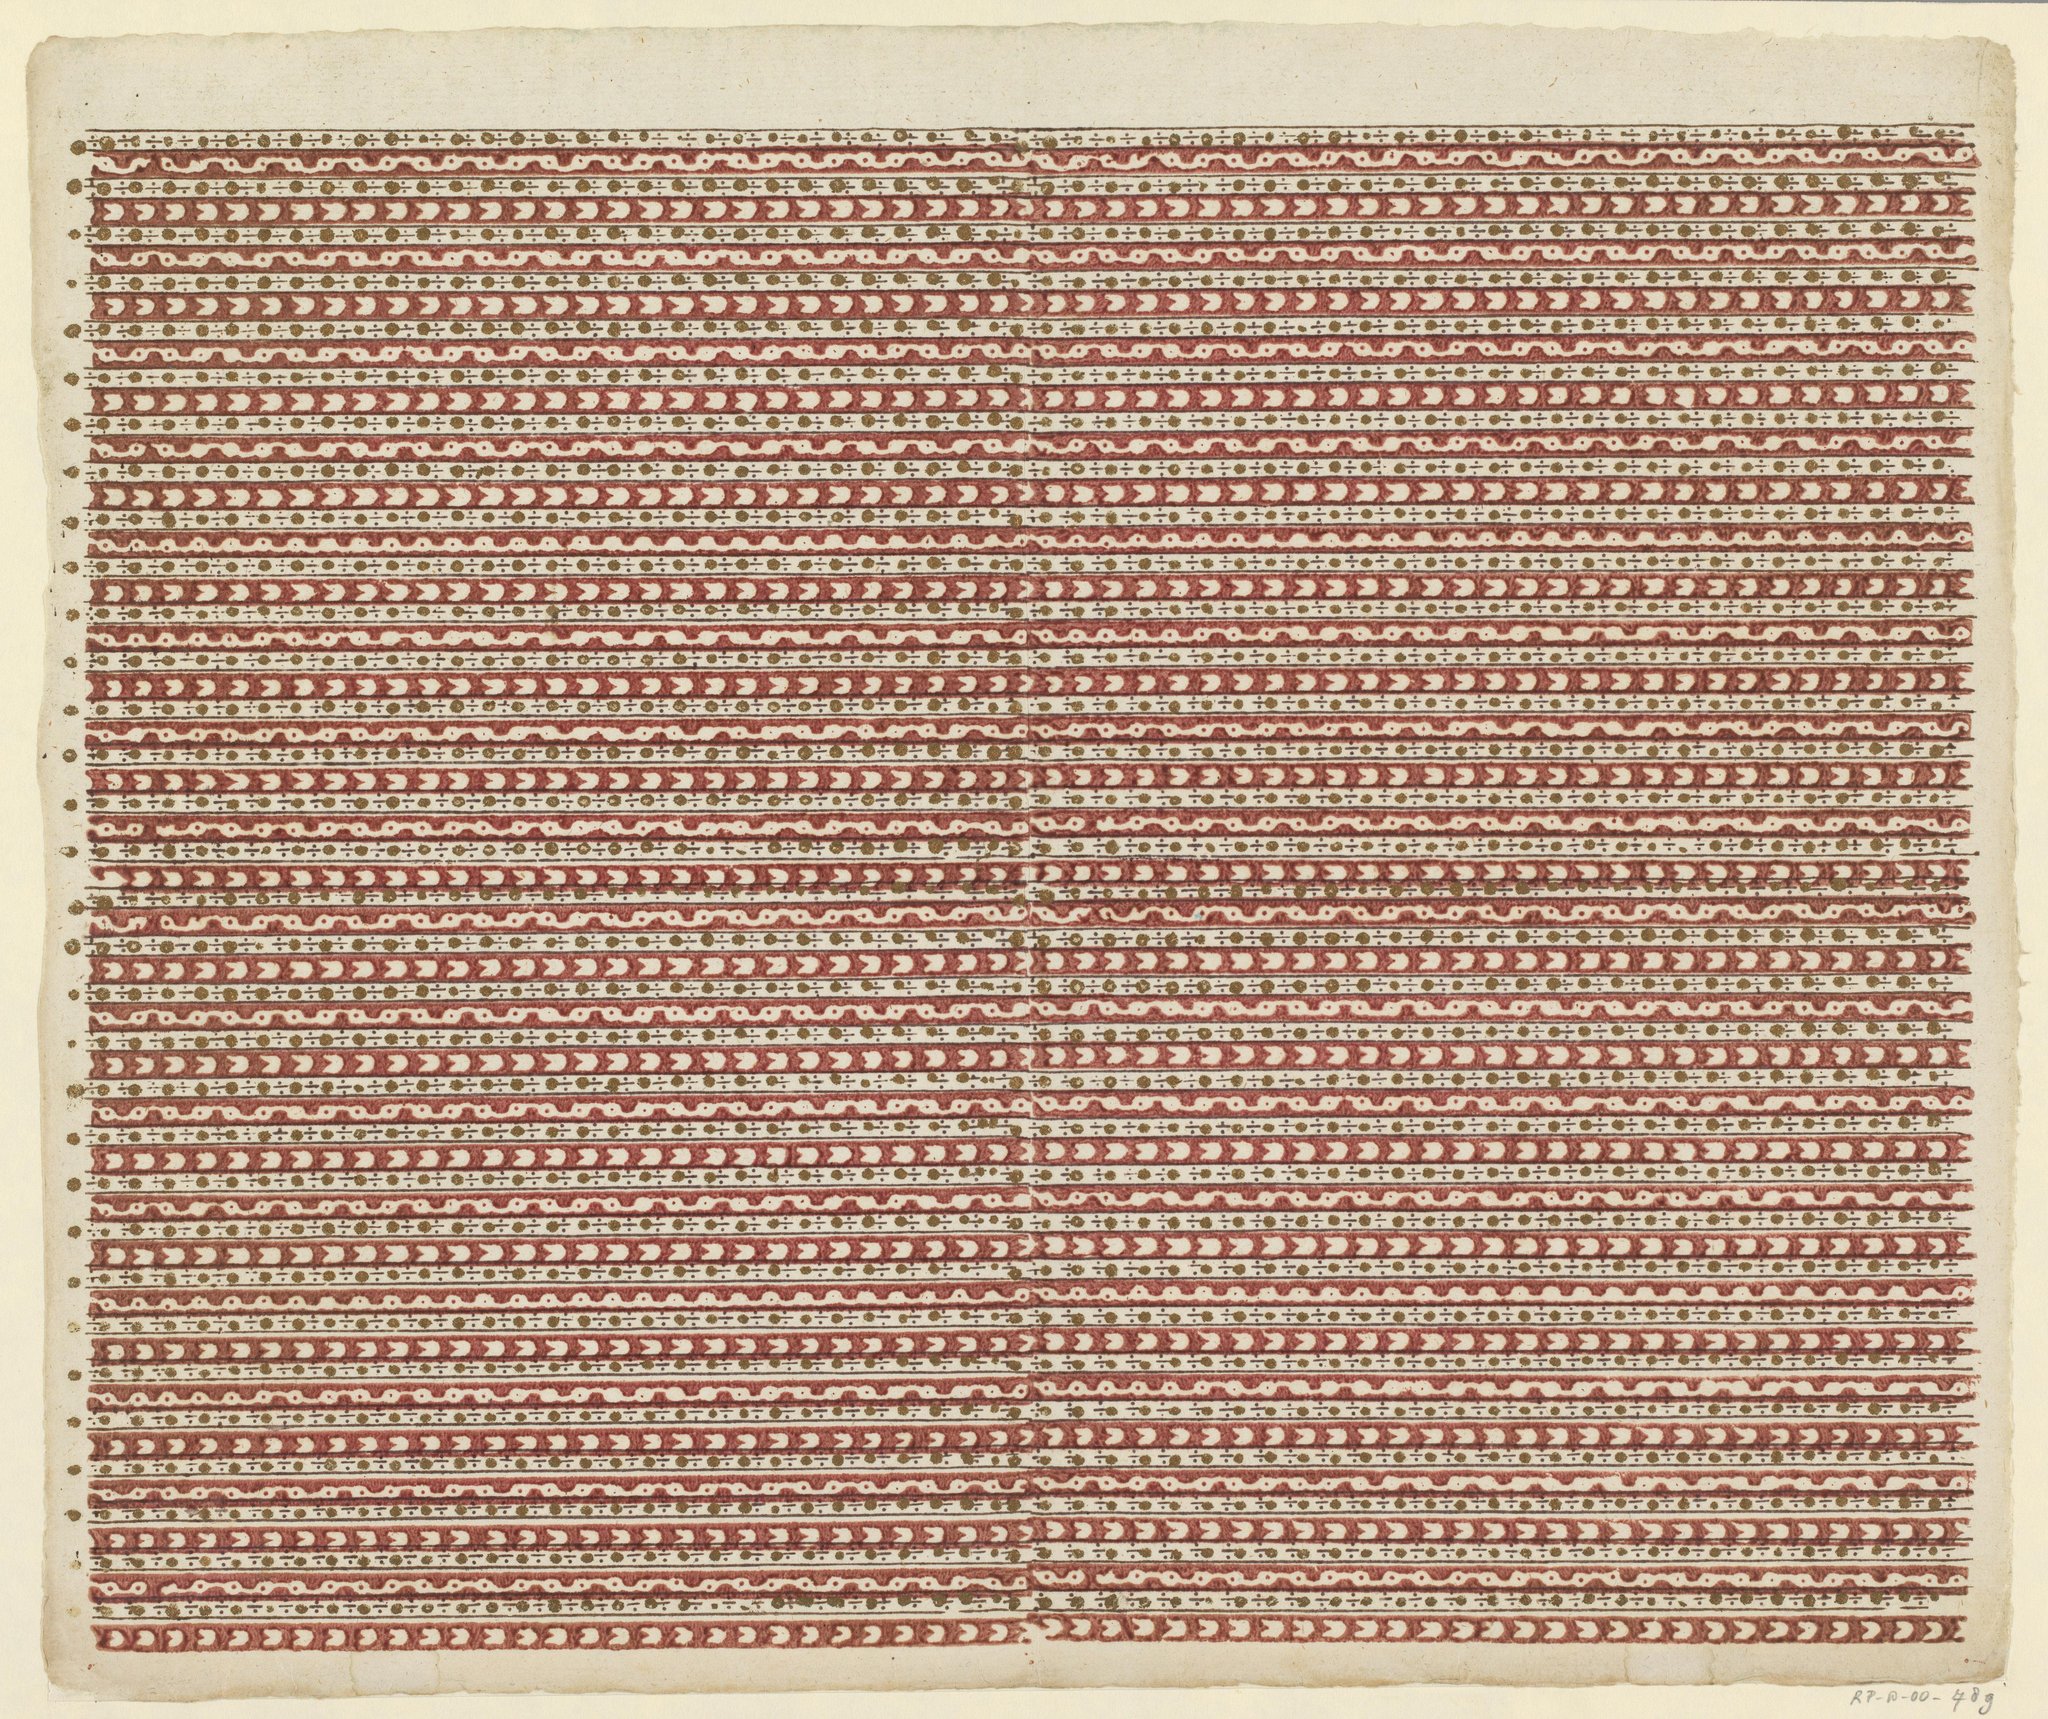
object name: printed paper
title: Blad met horizontaal banenpatroon van uitgespaarde motieven en stippen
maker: Anonymous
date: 1750-1950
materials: paint, lacquer, paper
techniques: printing block, lacquer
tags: ornament ~ geometric motifs